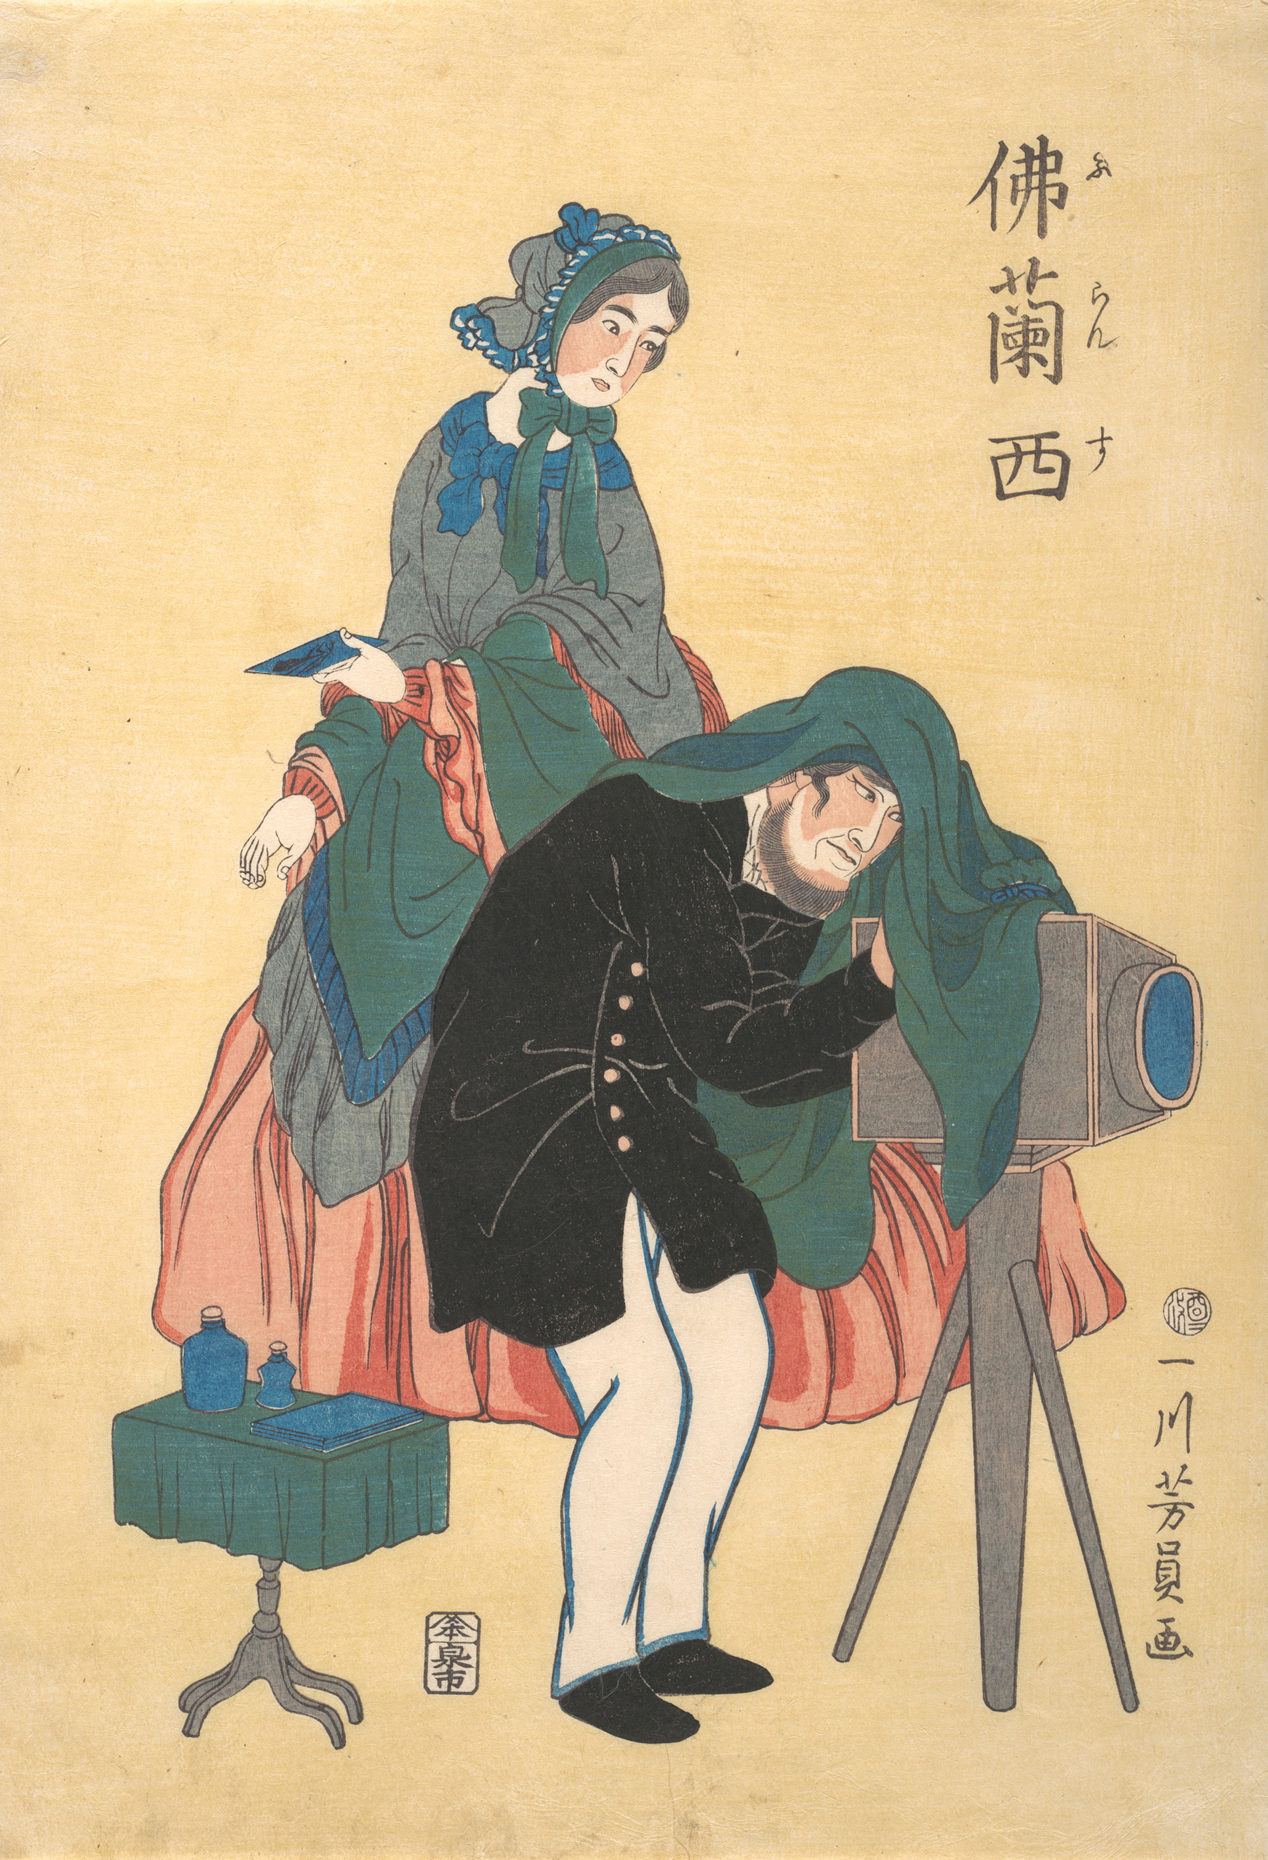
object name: print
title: French Photographer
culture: japanese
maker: utagawa yoshikazu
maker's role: artist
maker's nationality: japanese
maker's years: 1845-1870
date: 1861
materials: ink, paper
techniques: woodblock print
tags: photography,men,women,cameras